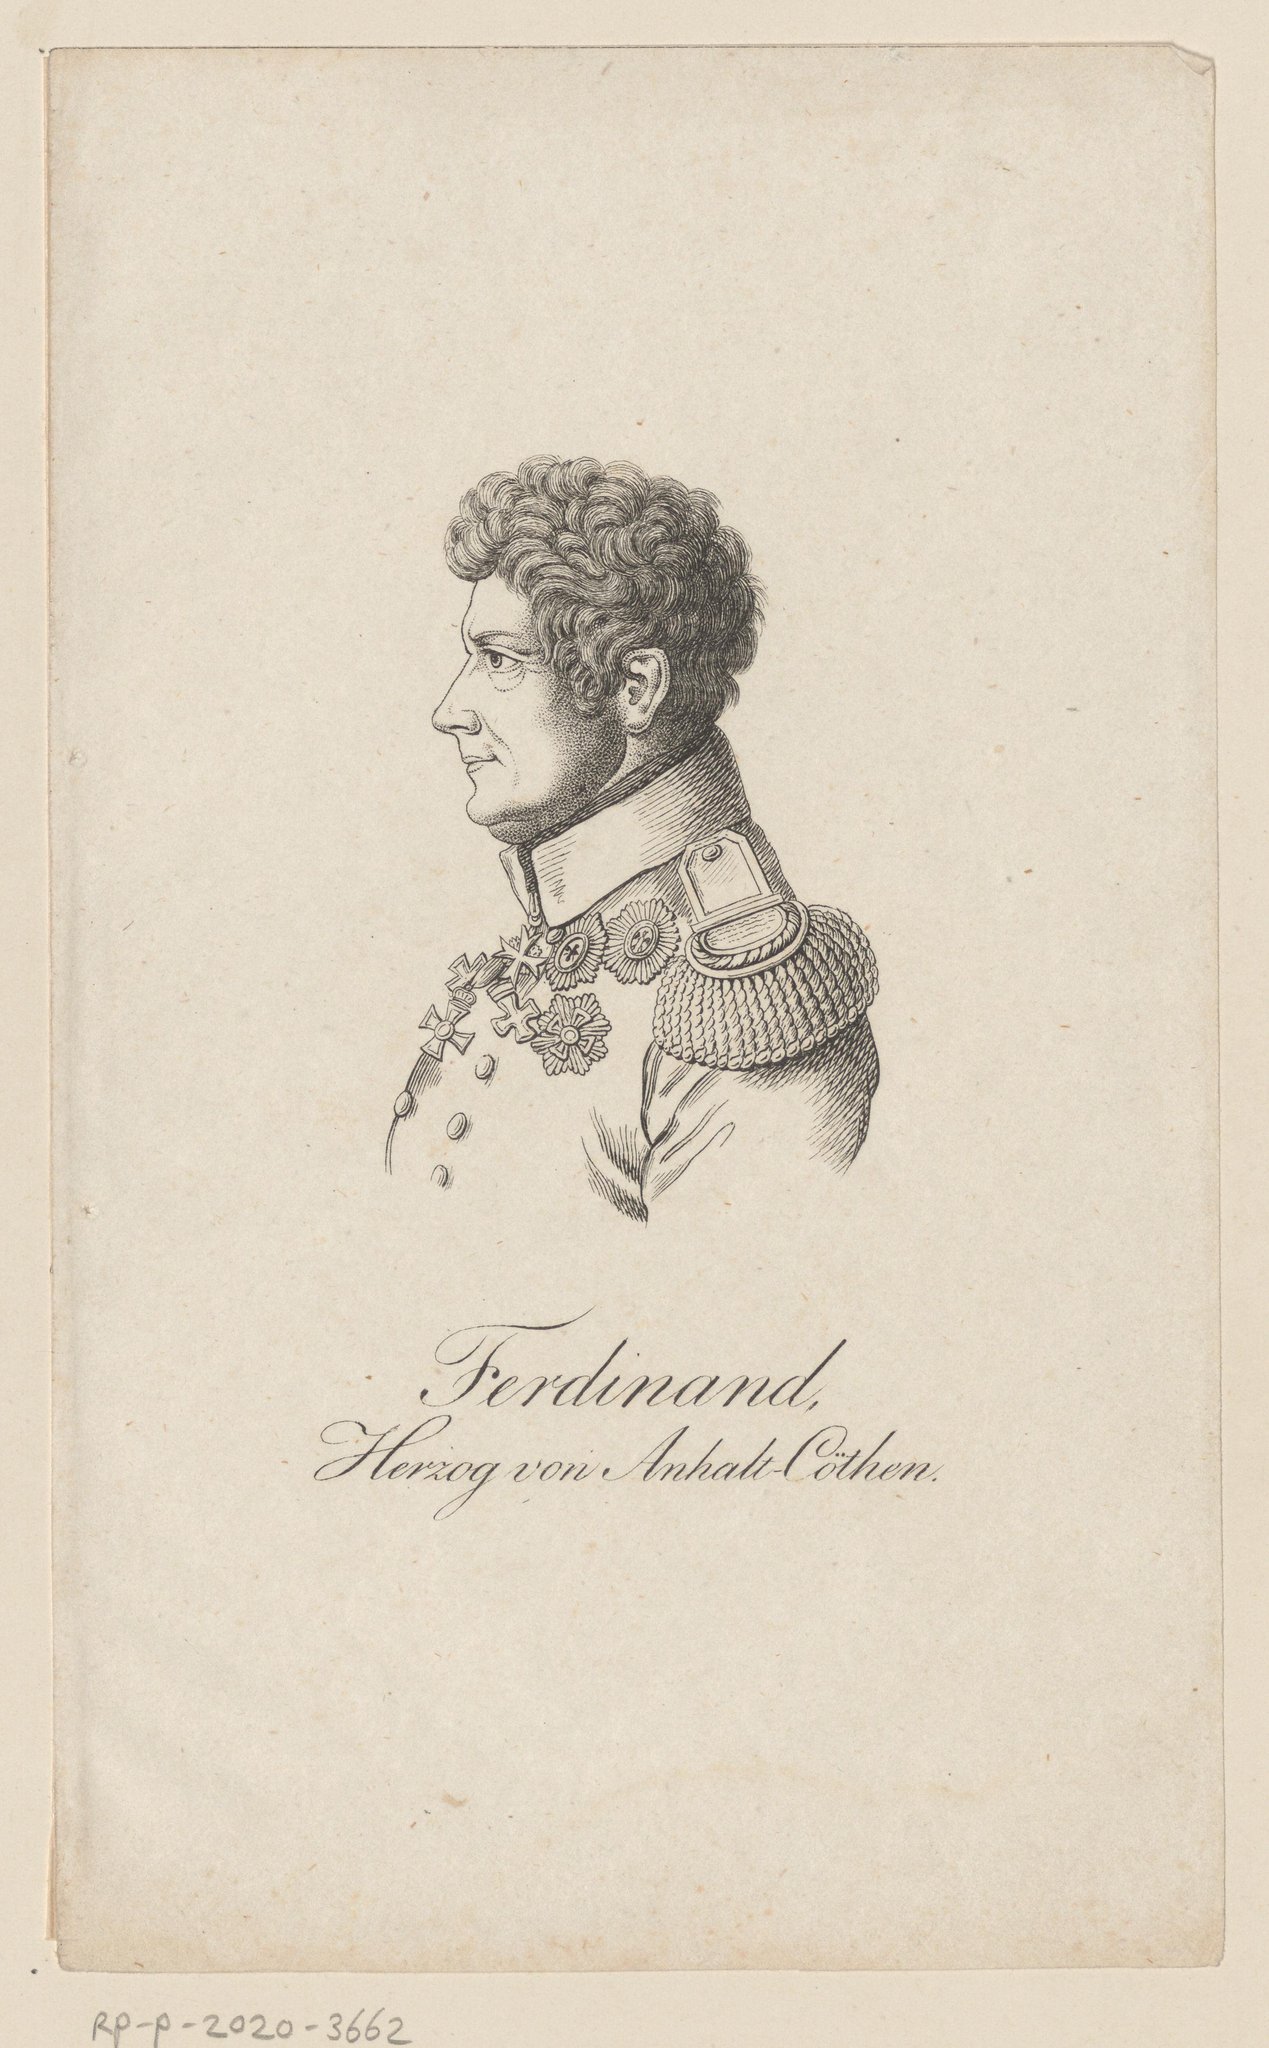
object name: print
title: Portret van Ferdinand Frederik van Anhalt-Köthen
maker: Anonymous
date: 1818-1830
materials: paper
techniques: etching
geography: germany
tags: historical persons